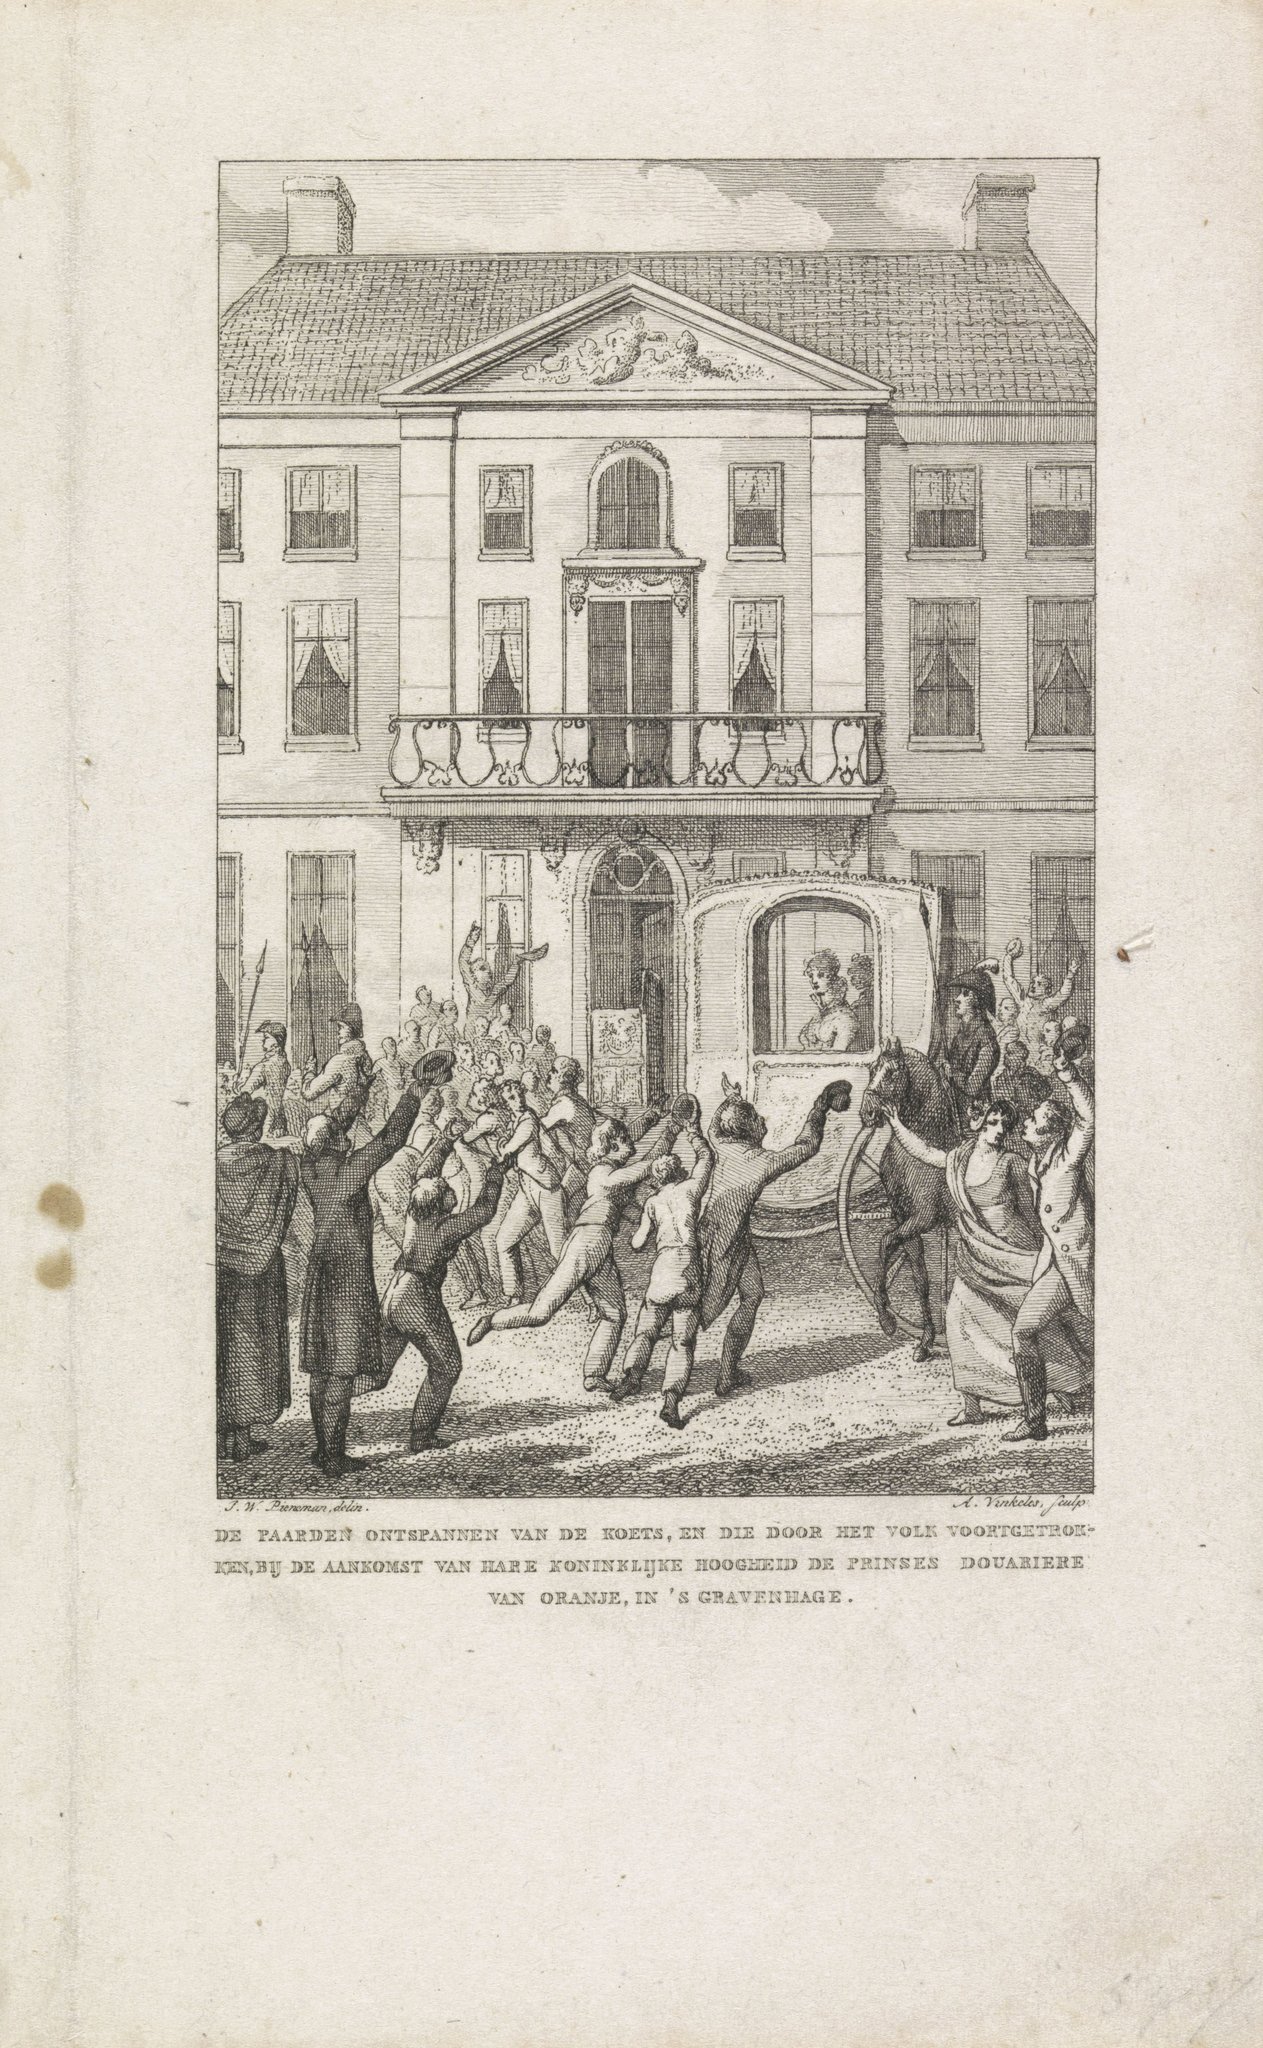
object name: print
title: Intrede van de beide Prinsessen Douarières in Den Haag, 1814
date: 1814-1816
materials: paper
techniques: engraving, etching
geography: netherlands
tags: berlin, draughtsman, wilhelmina of prussia (princess of orange), the hague, louise (prinses van oranje-nassau), four-wheeled, animal-drawn vehicle, e.g.: cab, carriage, coach (+ propulsion of vehicle, ship, etc. by human power), triumphal entry and public reception, pageant, 'entrée solennelle', 'joyeuse entrée'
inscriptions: collector's mark: Lugt 2166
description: De paarden voor de koets met de beide Prinsessen Douarières (Wilhelmina van Pruisen, de weduwe van prins Willem V en haar dochter prinses Louise, de weduwe van Karel van Brunswijk-Wolfenbüttel) worden ontspannen en de koets door het volk verder getrokken, voor het Paleis Noordeinde te Den Haag.